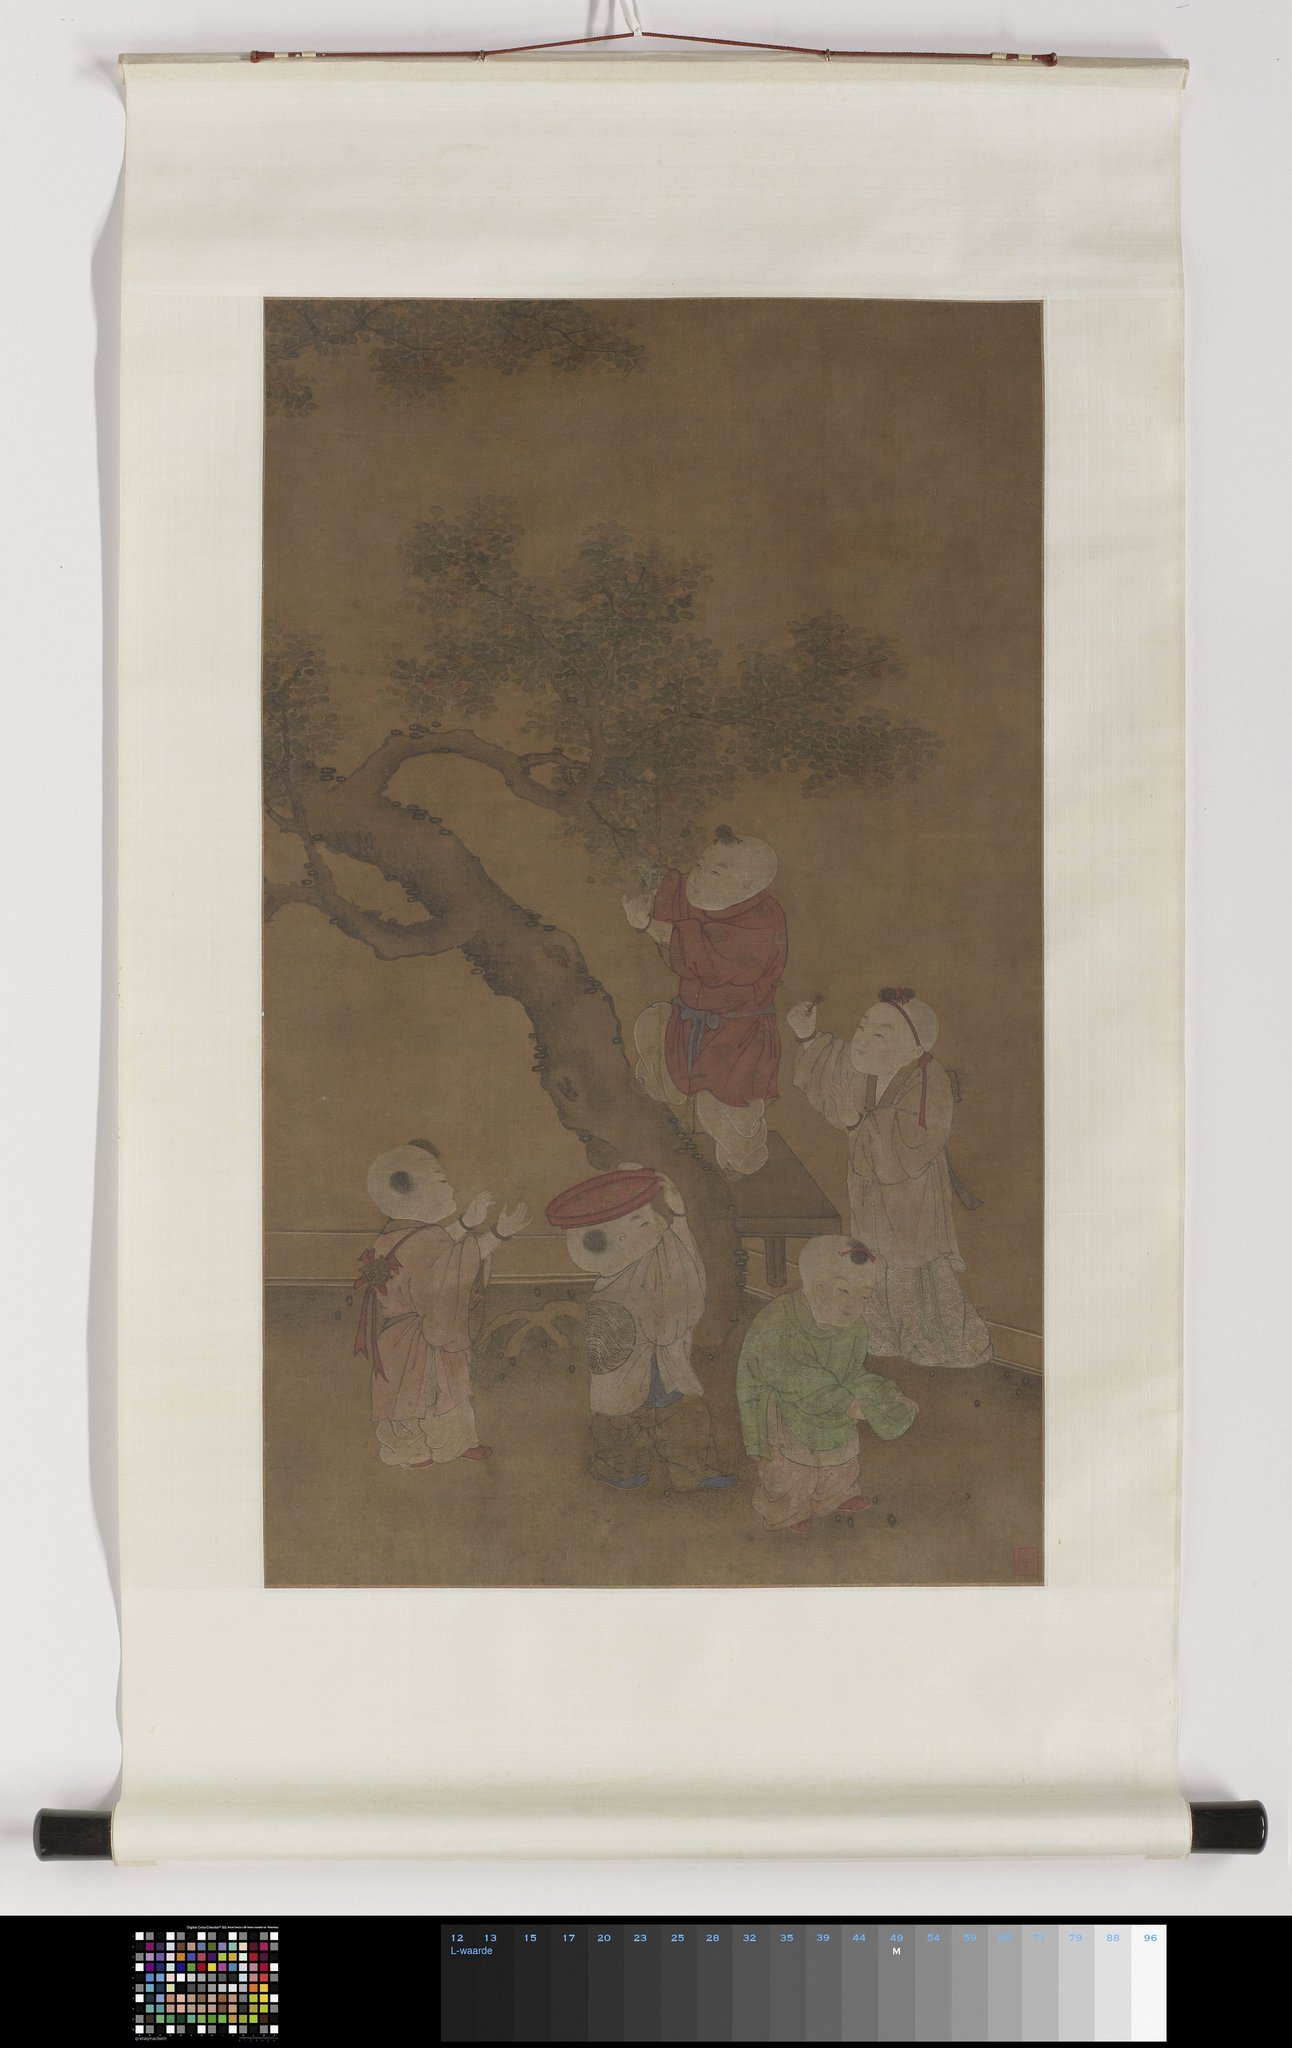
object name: hanging scroll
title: Rolschildering met een voorstelling van vijf jongens die dadelpruimen plukken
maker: Anonymous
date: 1500-1625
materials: gold, ink, silk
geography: china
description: Rolschildering met een voorstelling van vijf jongens die dadelpruimen plukken. Vrije kopie naar een anoniem werk uit de Song-periode in het Paleismuseum te Taipei. In houten doos.